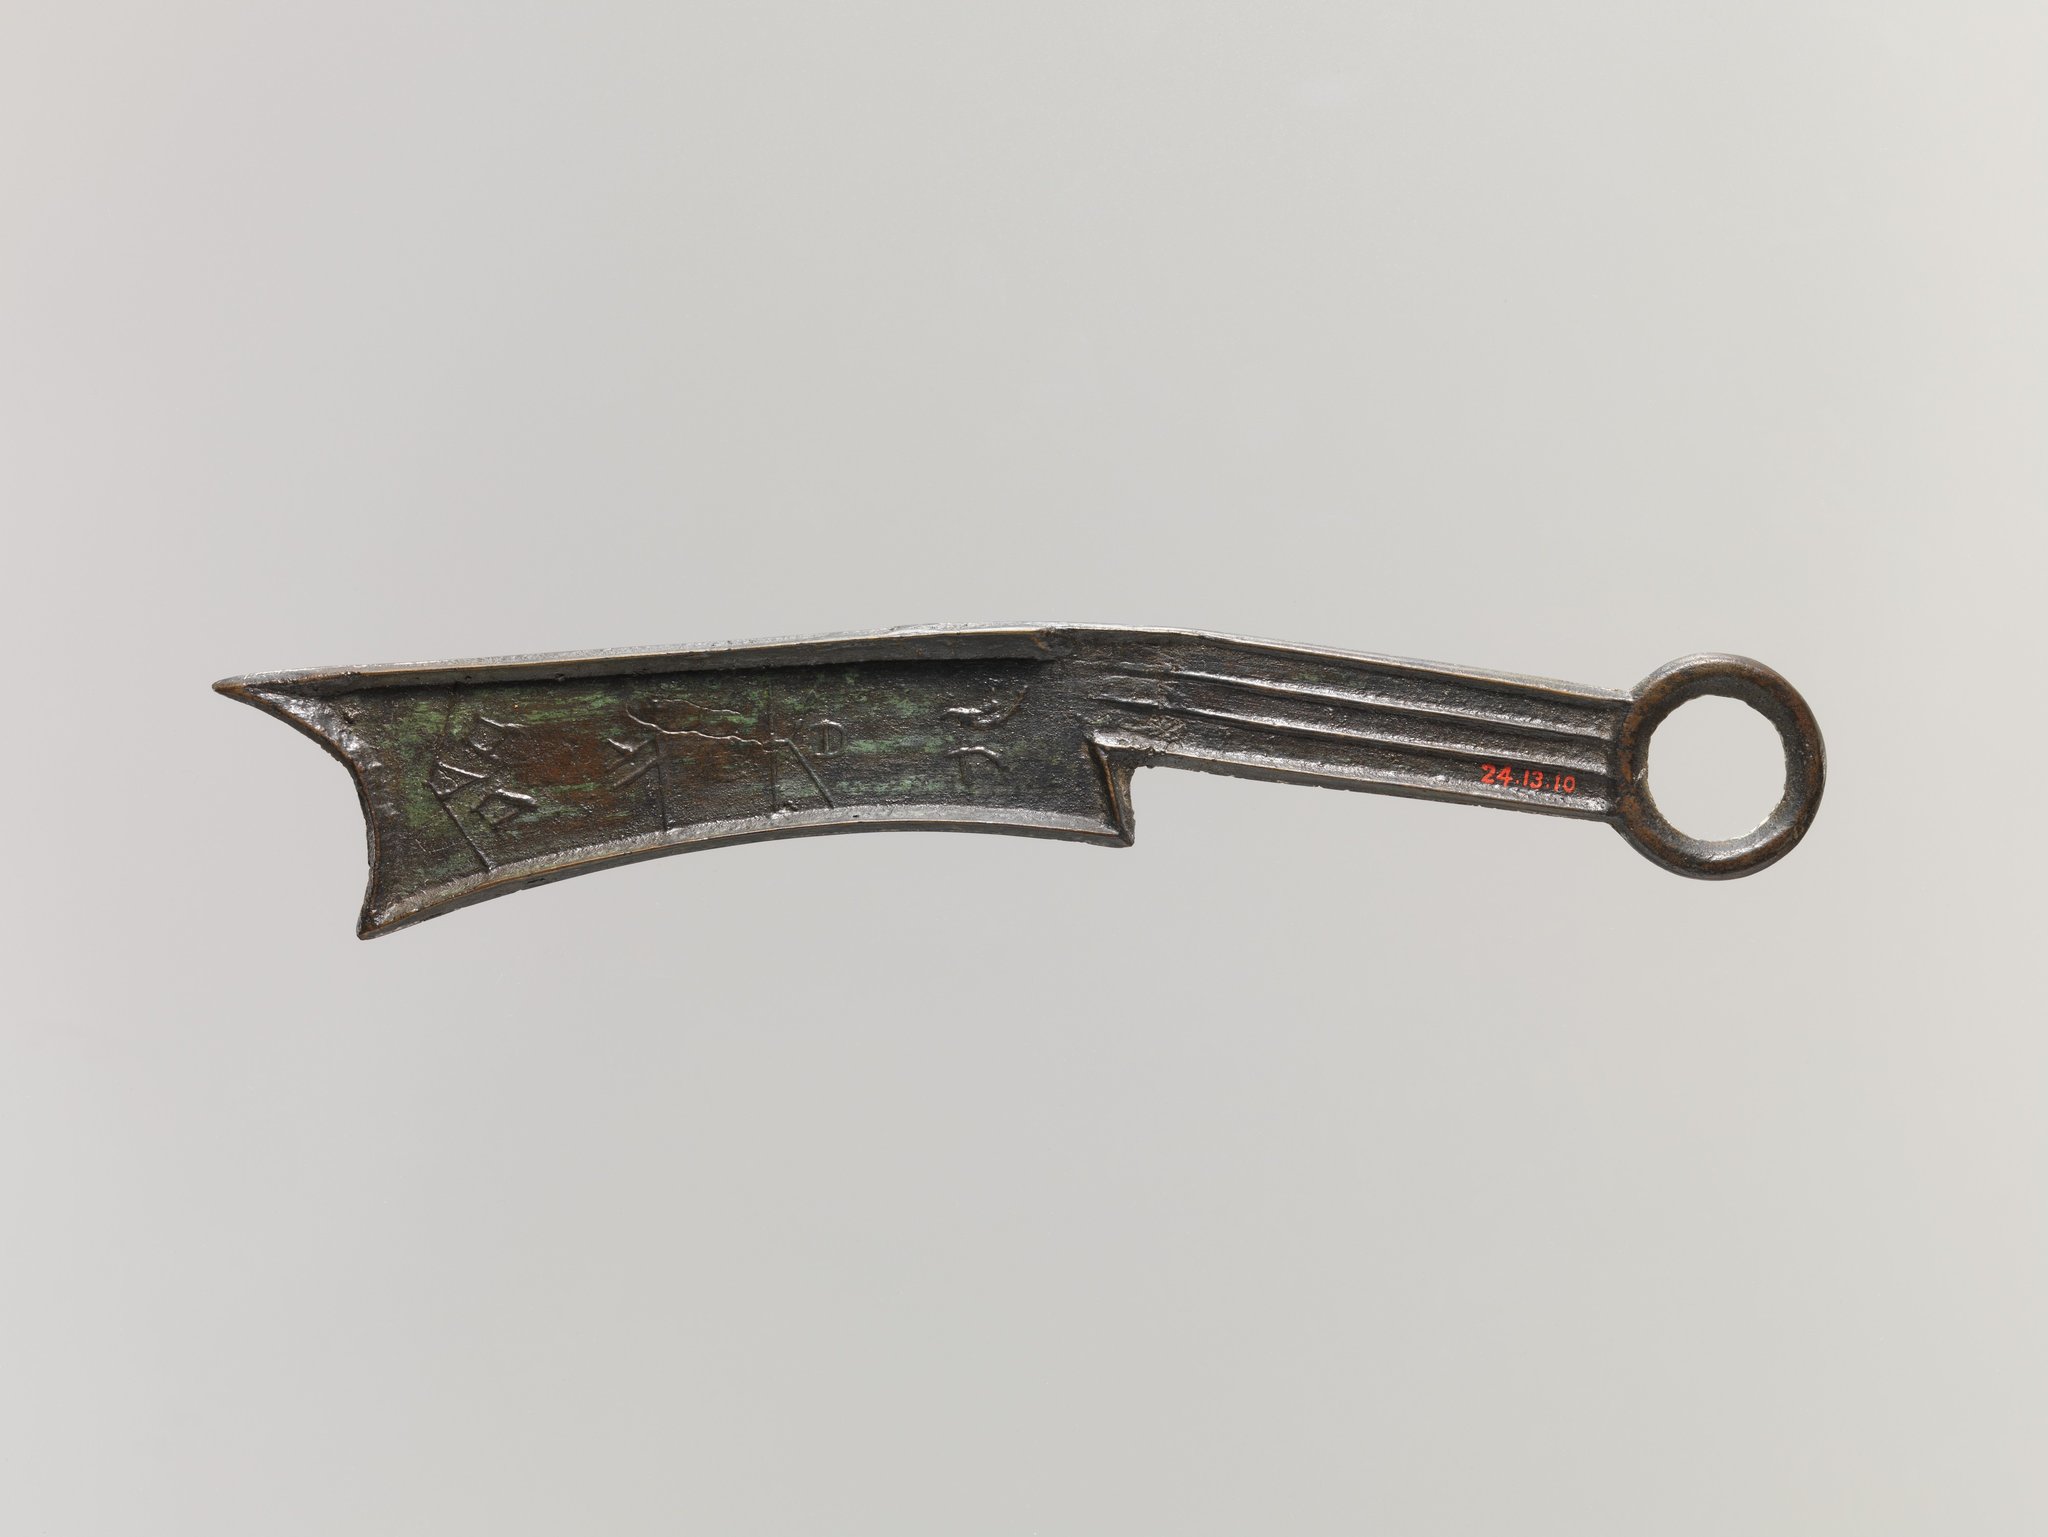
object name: knife coin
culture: chinese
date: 206 BCE-220 CE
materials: bronze